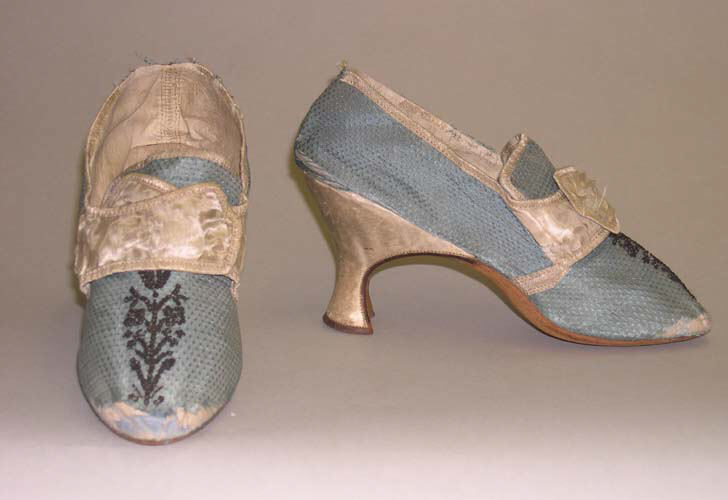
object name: shoe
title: Shoes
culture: european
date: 1776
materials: leather, silk